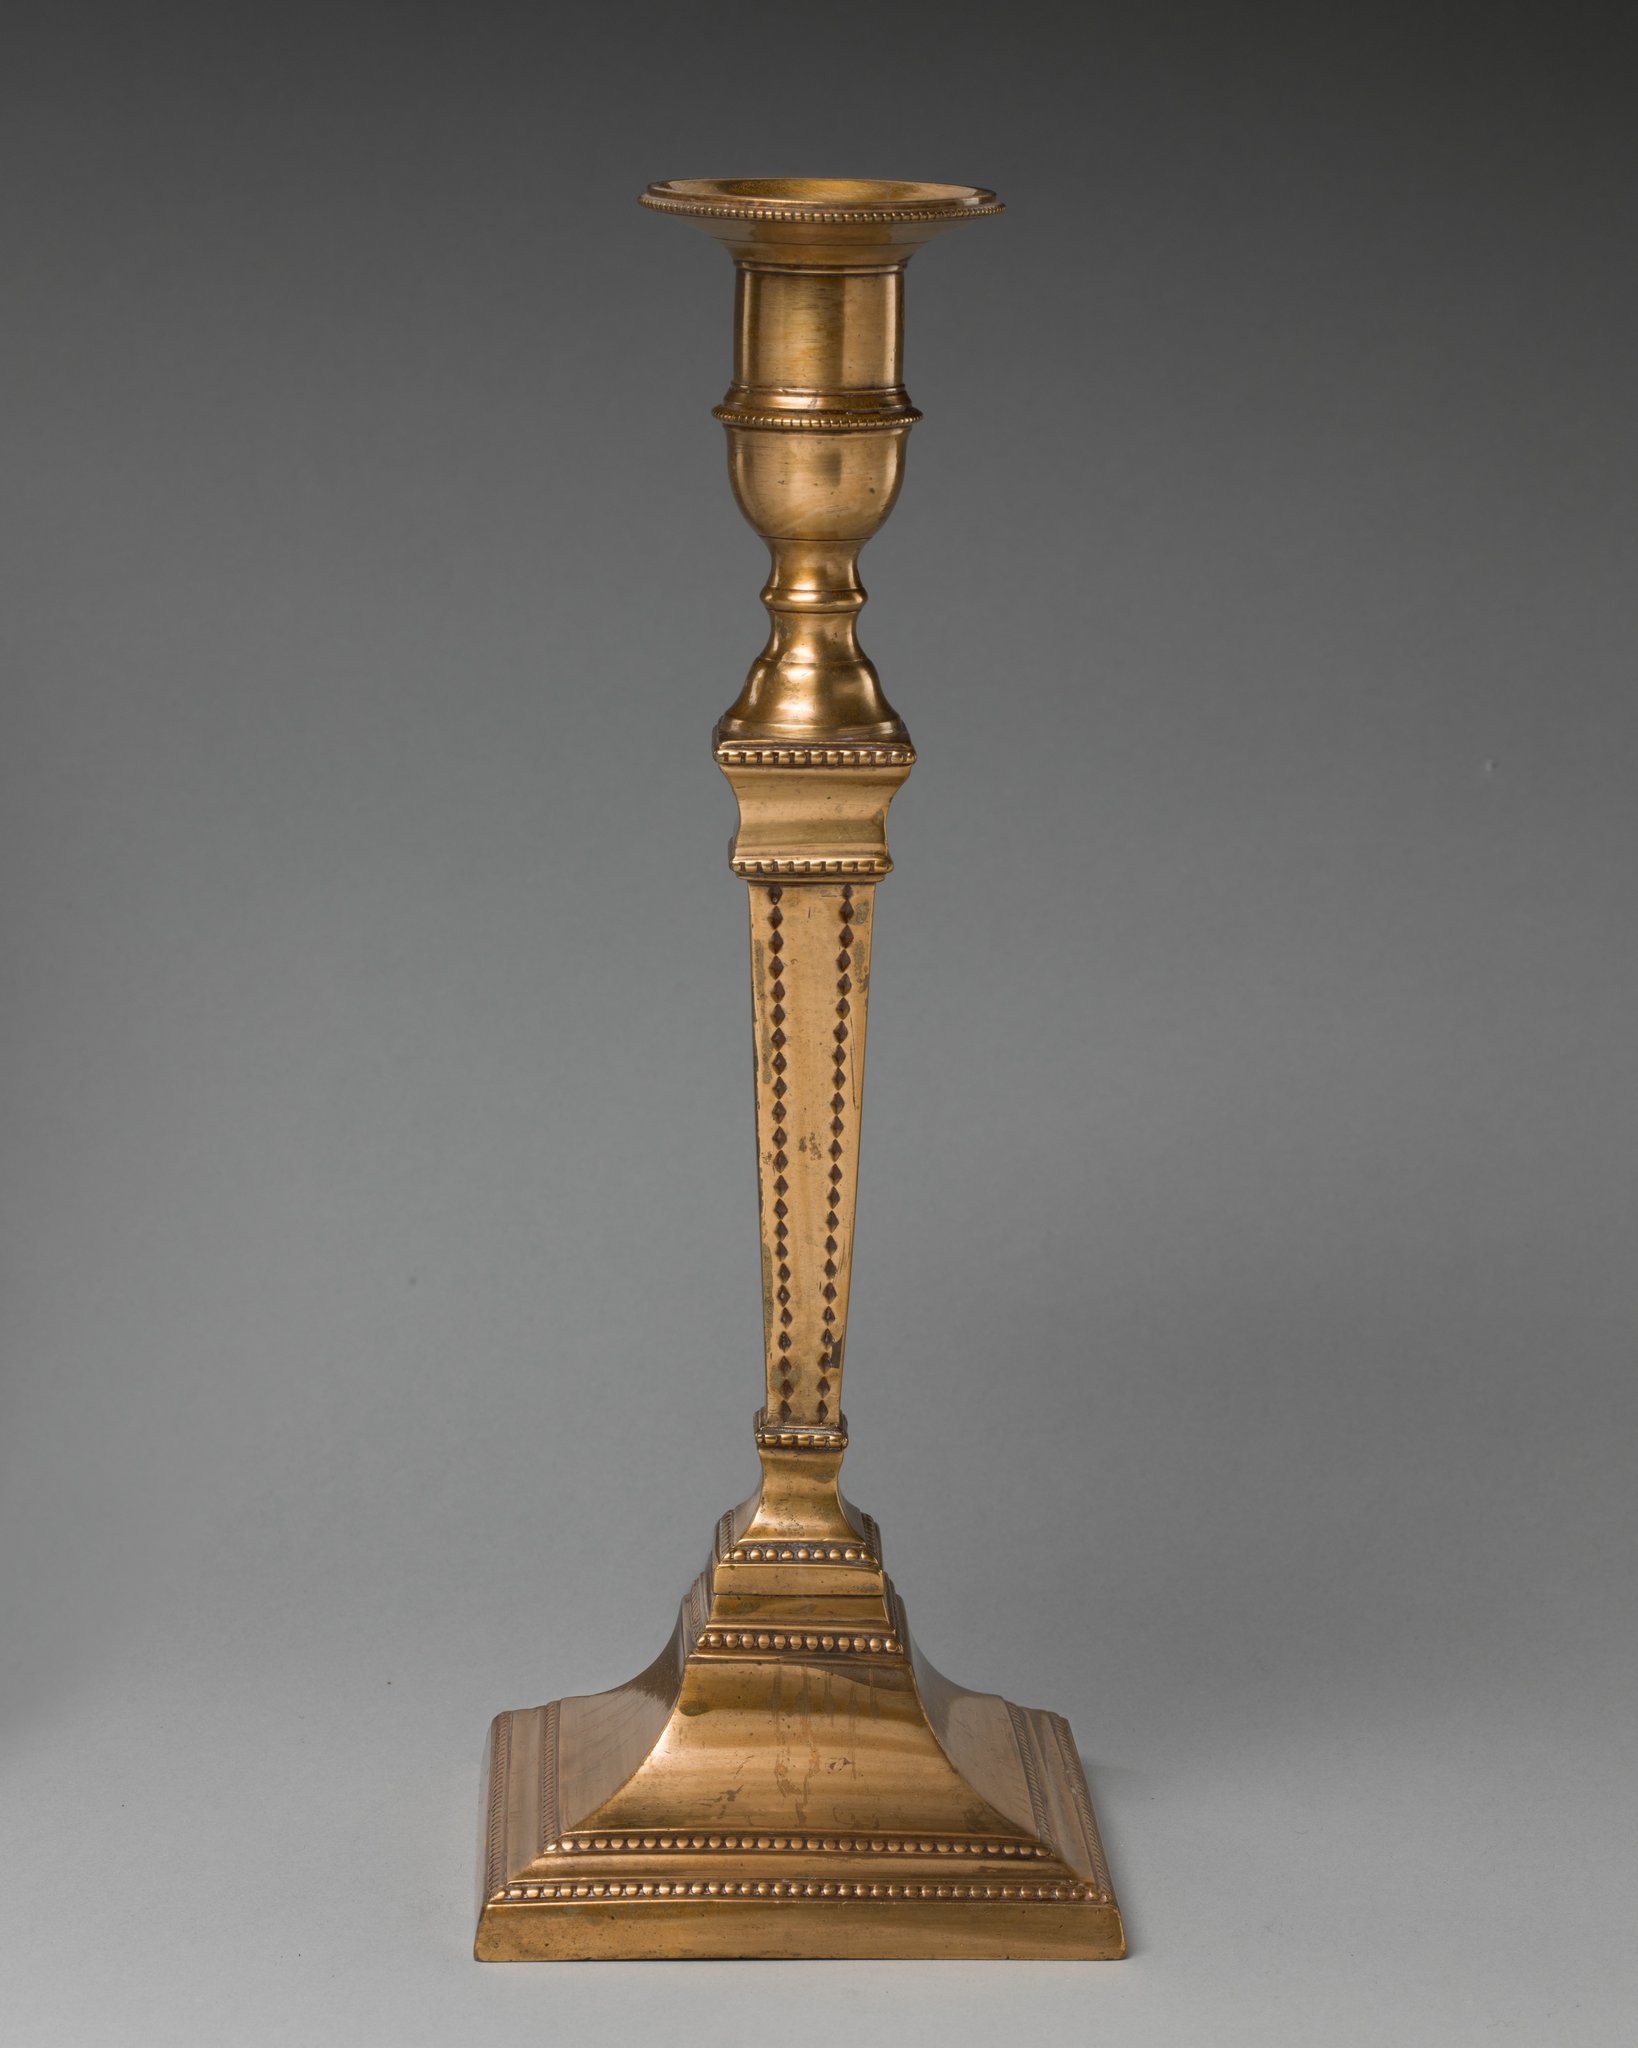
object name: candlestick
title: Pair of candlesticks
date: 1780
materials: brass